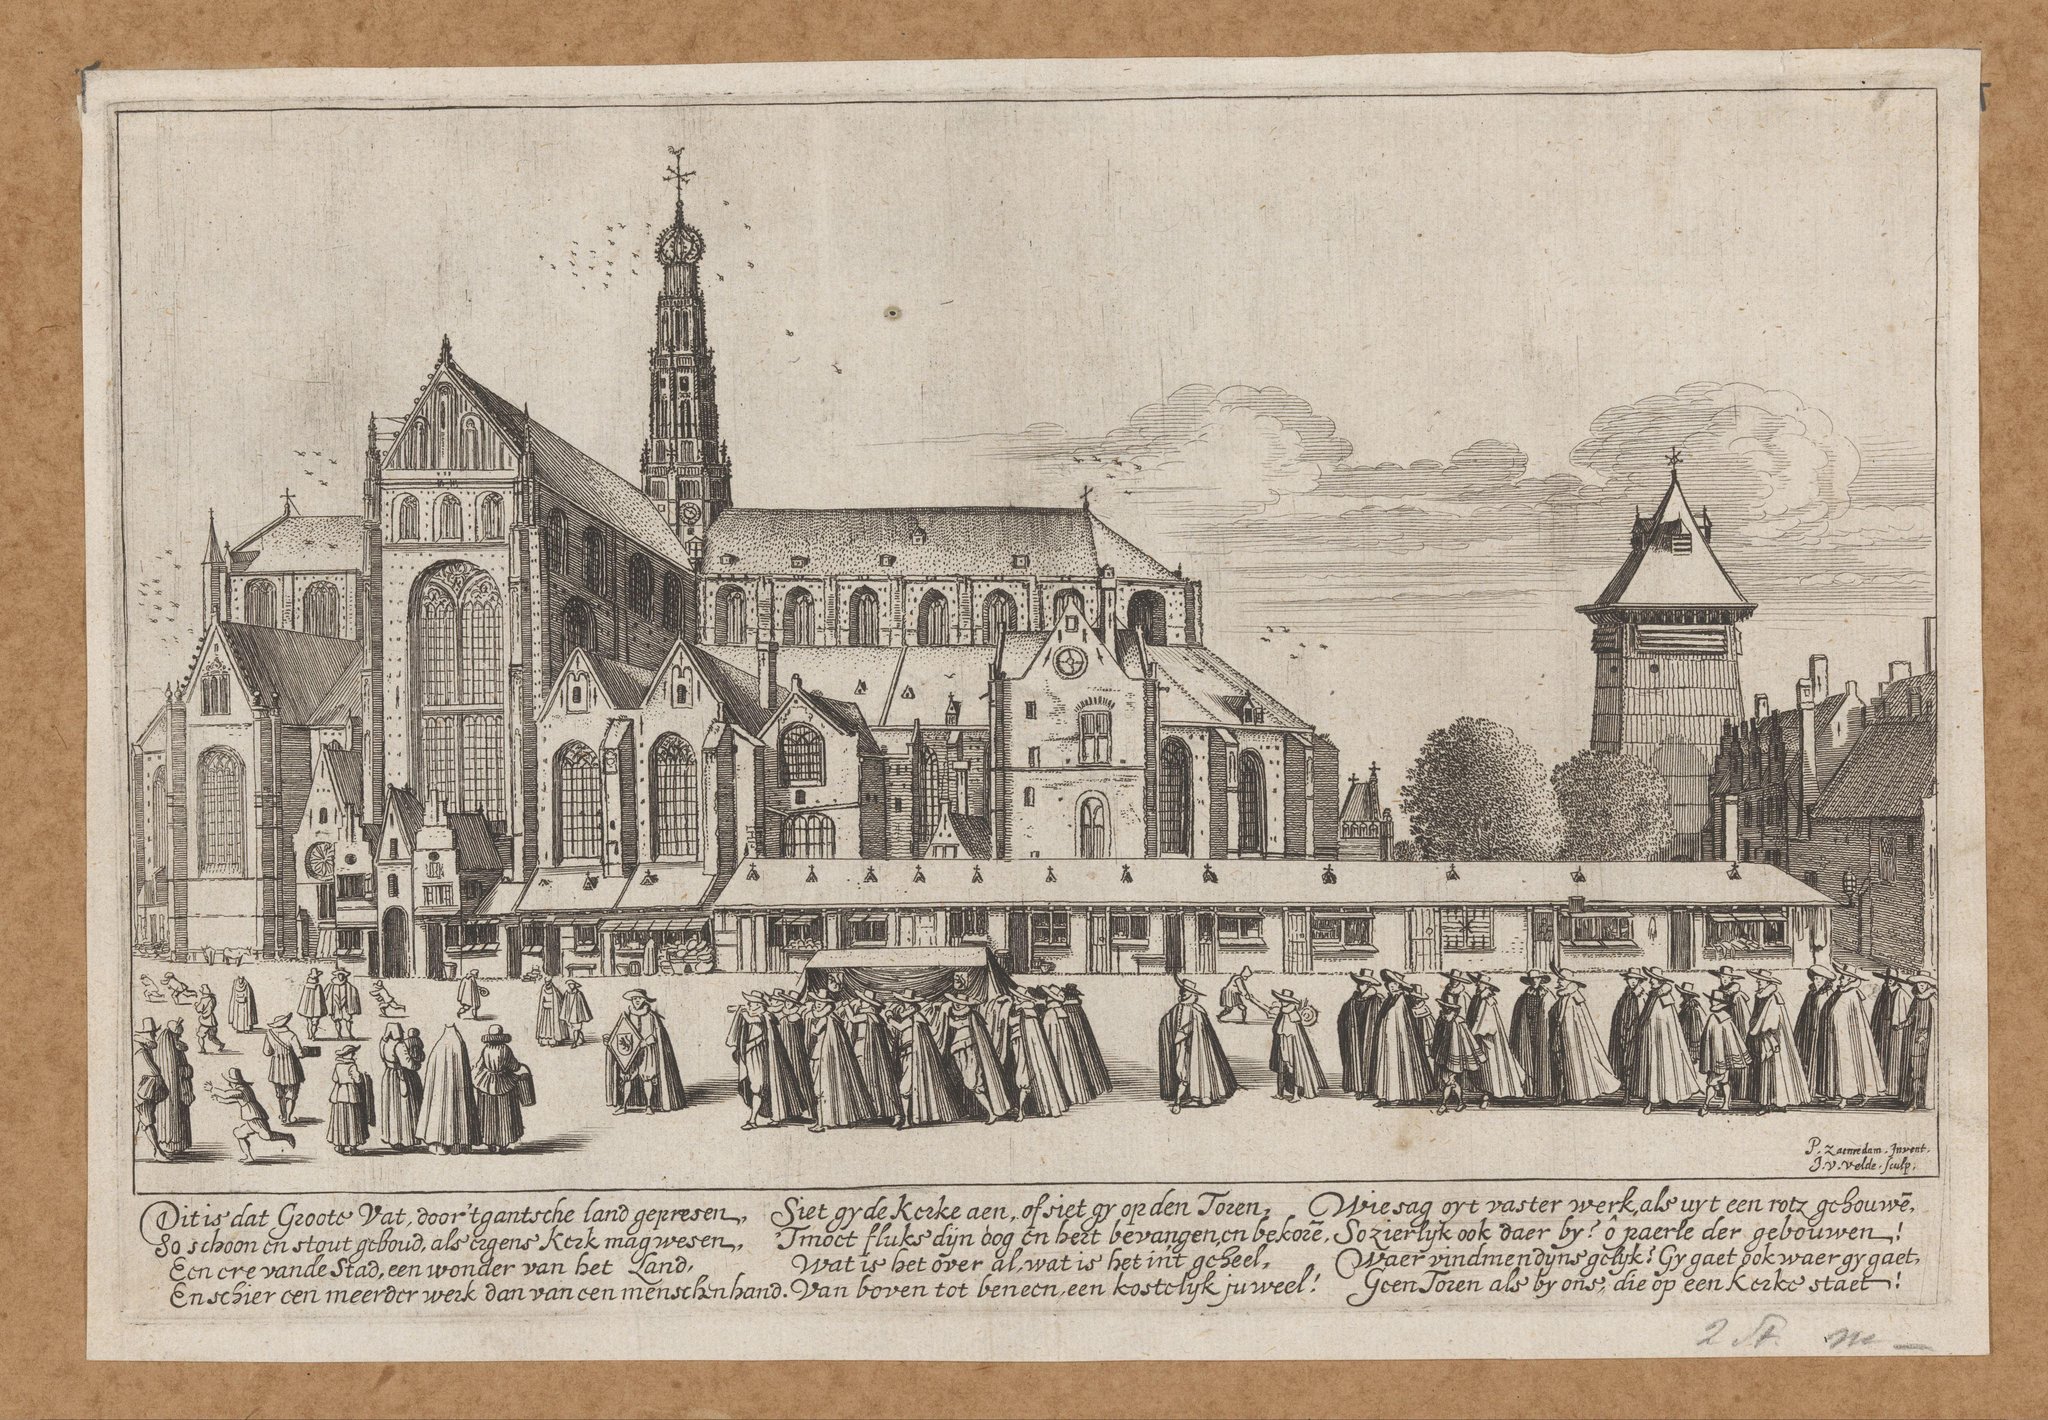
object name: book illustration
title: Gezicht op de Sint-Bavokerk, vanuit het zuidoosten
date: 1628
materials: paper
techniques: engraving, etching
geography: haarlem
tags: church (exterior), tower (of house or building)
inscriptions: collector's mark: Lugt 2233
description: Prent uit: Ampzing, Samuel. Beschryvinge ende lof der stad Haerlem in Holland (…). Haarlem: Adriaen Roman (I), 1628, p. 288-289.